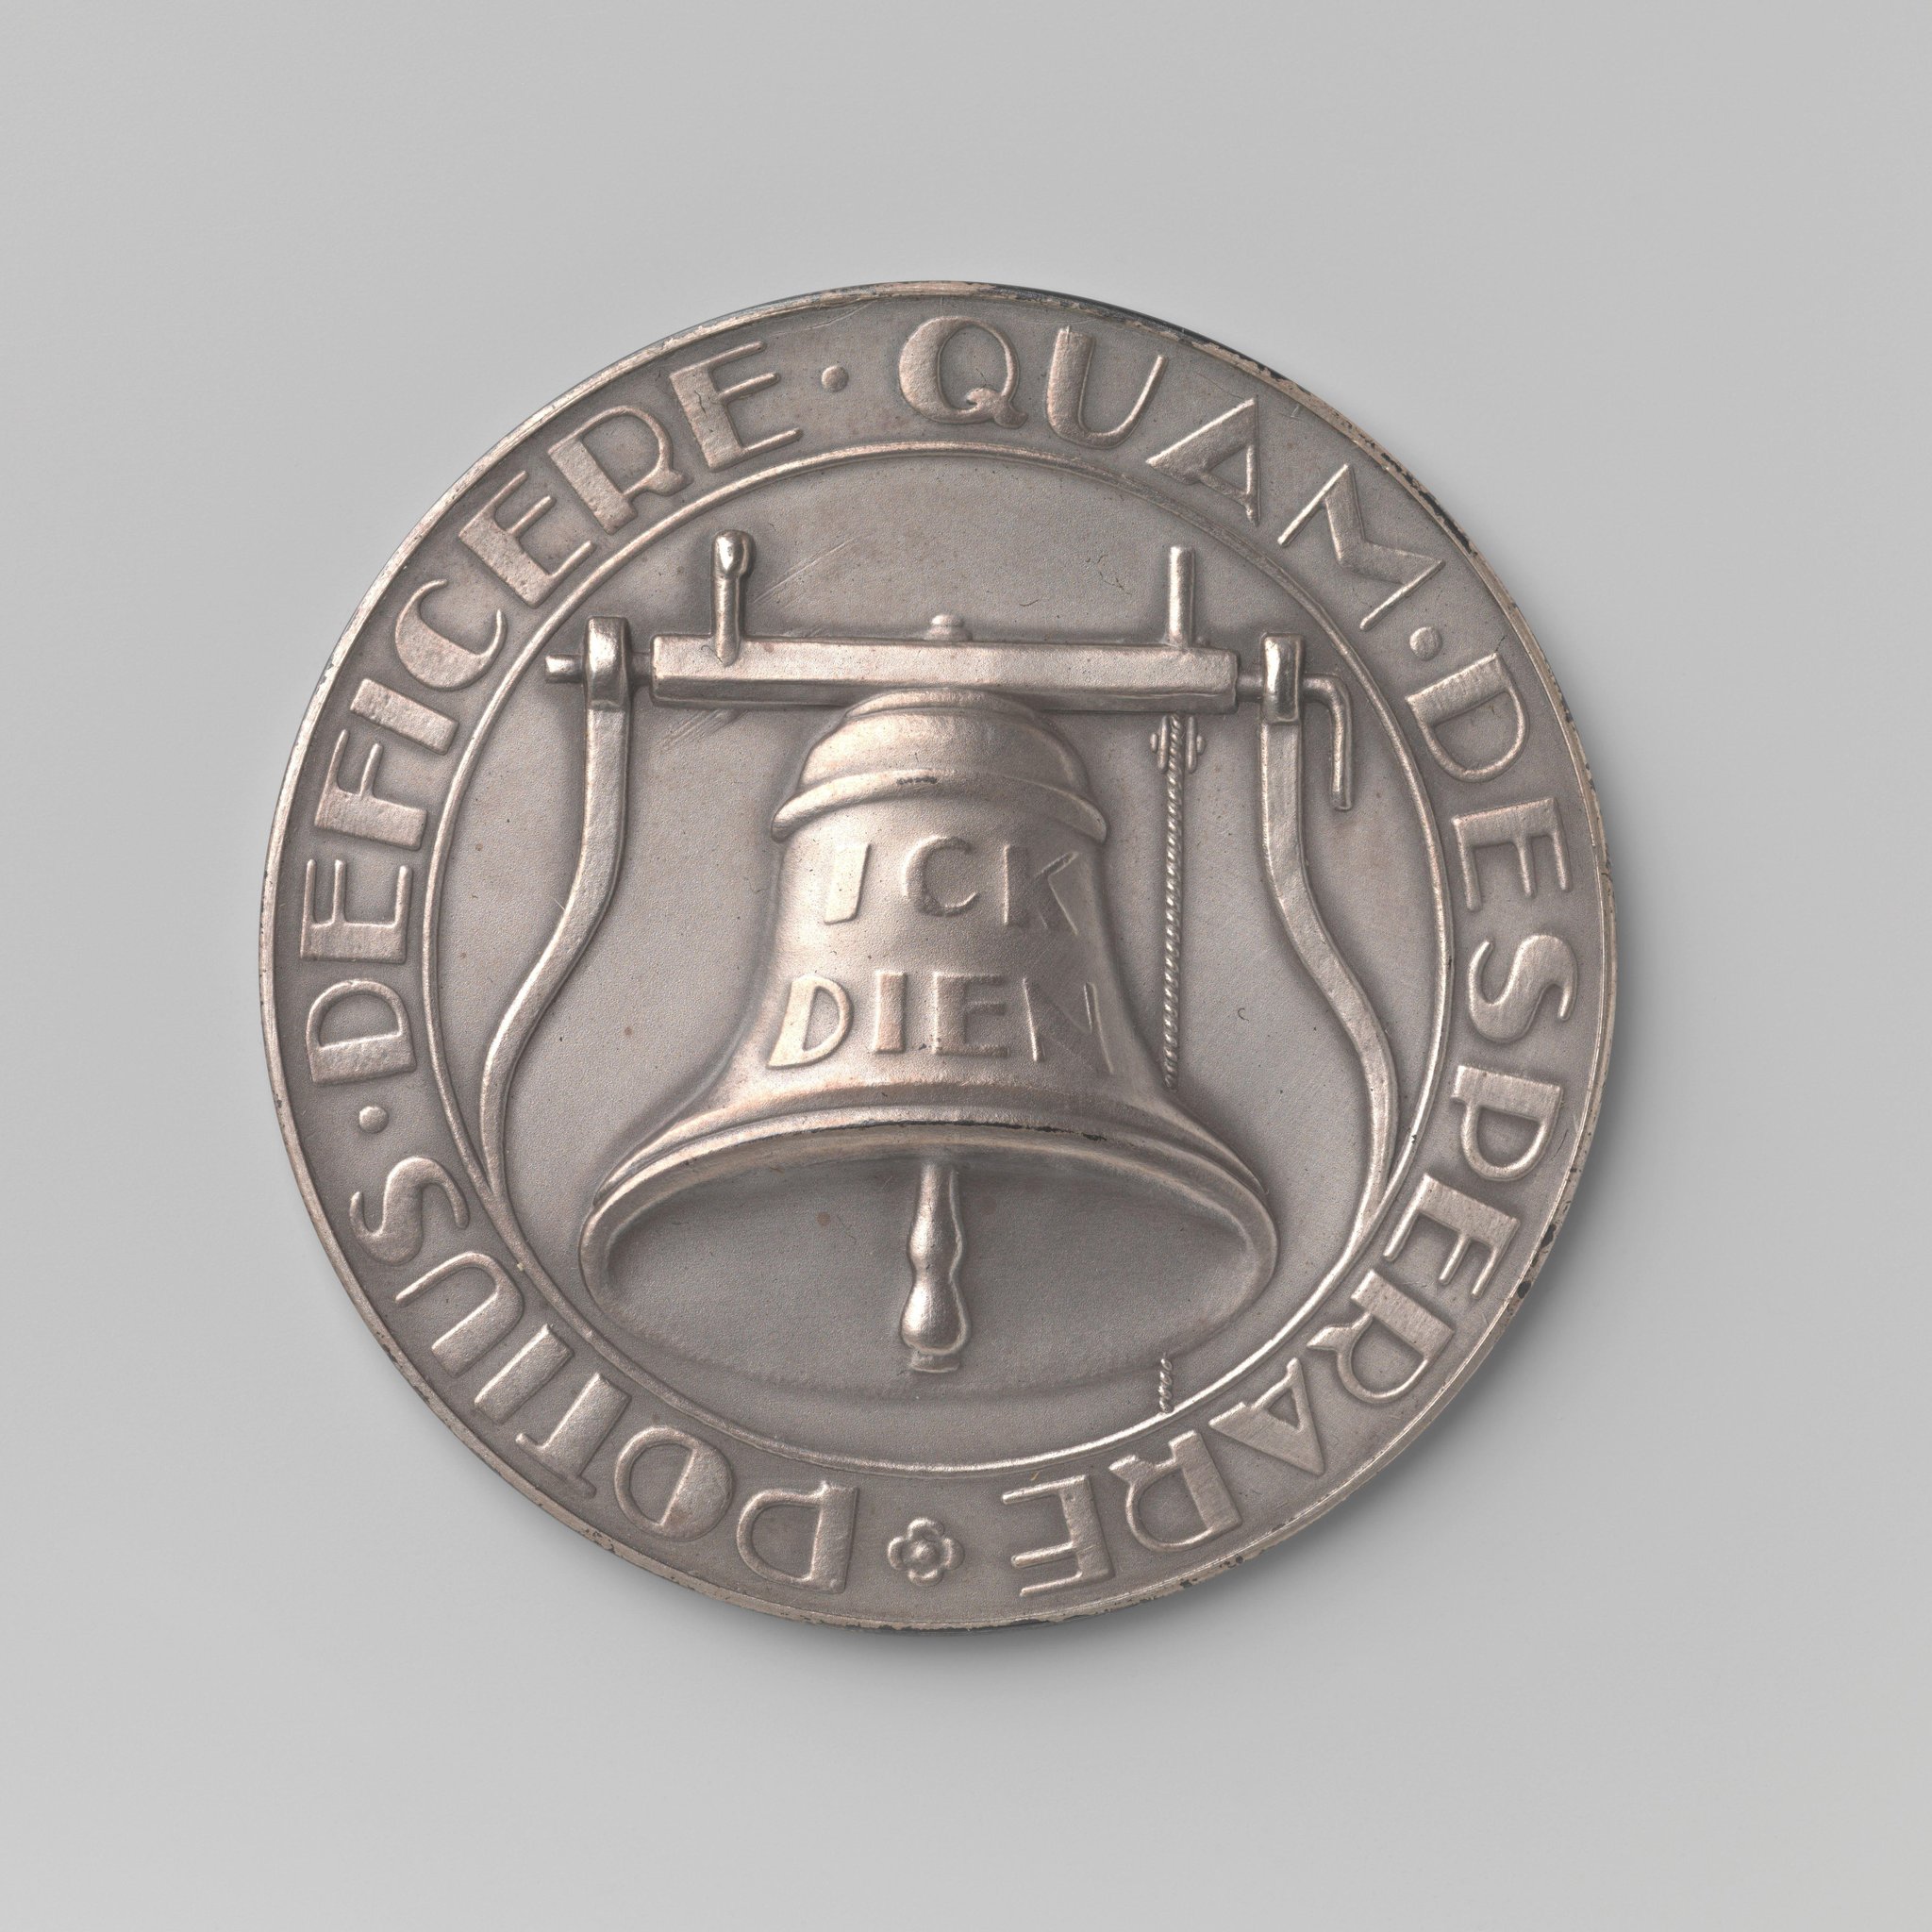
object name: medal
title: Erepenning van het Amsterdamsch Lyceum op naam van het Koninklijk Oudheidkundig Genootschap bij haar vijfenzeventigjarig bestaan 1933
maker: chris van der hoef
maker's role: ceramicist, draughtsman, sculptor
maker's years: 1875-1933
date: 1933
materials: silver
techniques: striking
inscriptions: inscription: ‘HET AMSTERDAMSCH LYCEUM / AAN HET / KON. OUDHEIDKUNDIG / GENOOTSCHAP / TER GELEGENHEID VAN / ZIJN 75-JARIG BESTAAN / 1933’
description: Zilveren penning, op de voorzijde een alarmklok, met omschrift, op de keerzijde een inscriptieruimte binnen een eiken- en lauwerkrans, met inscriptie.